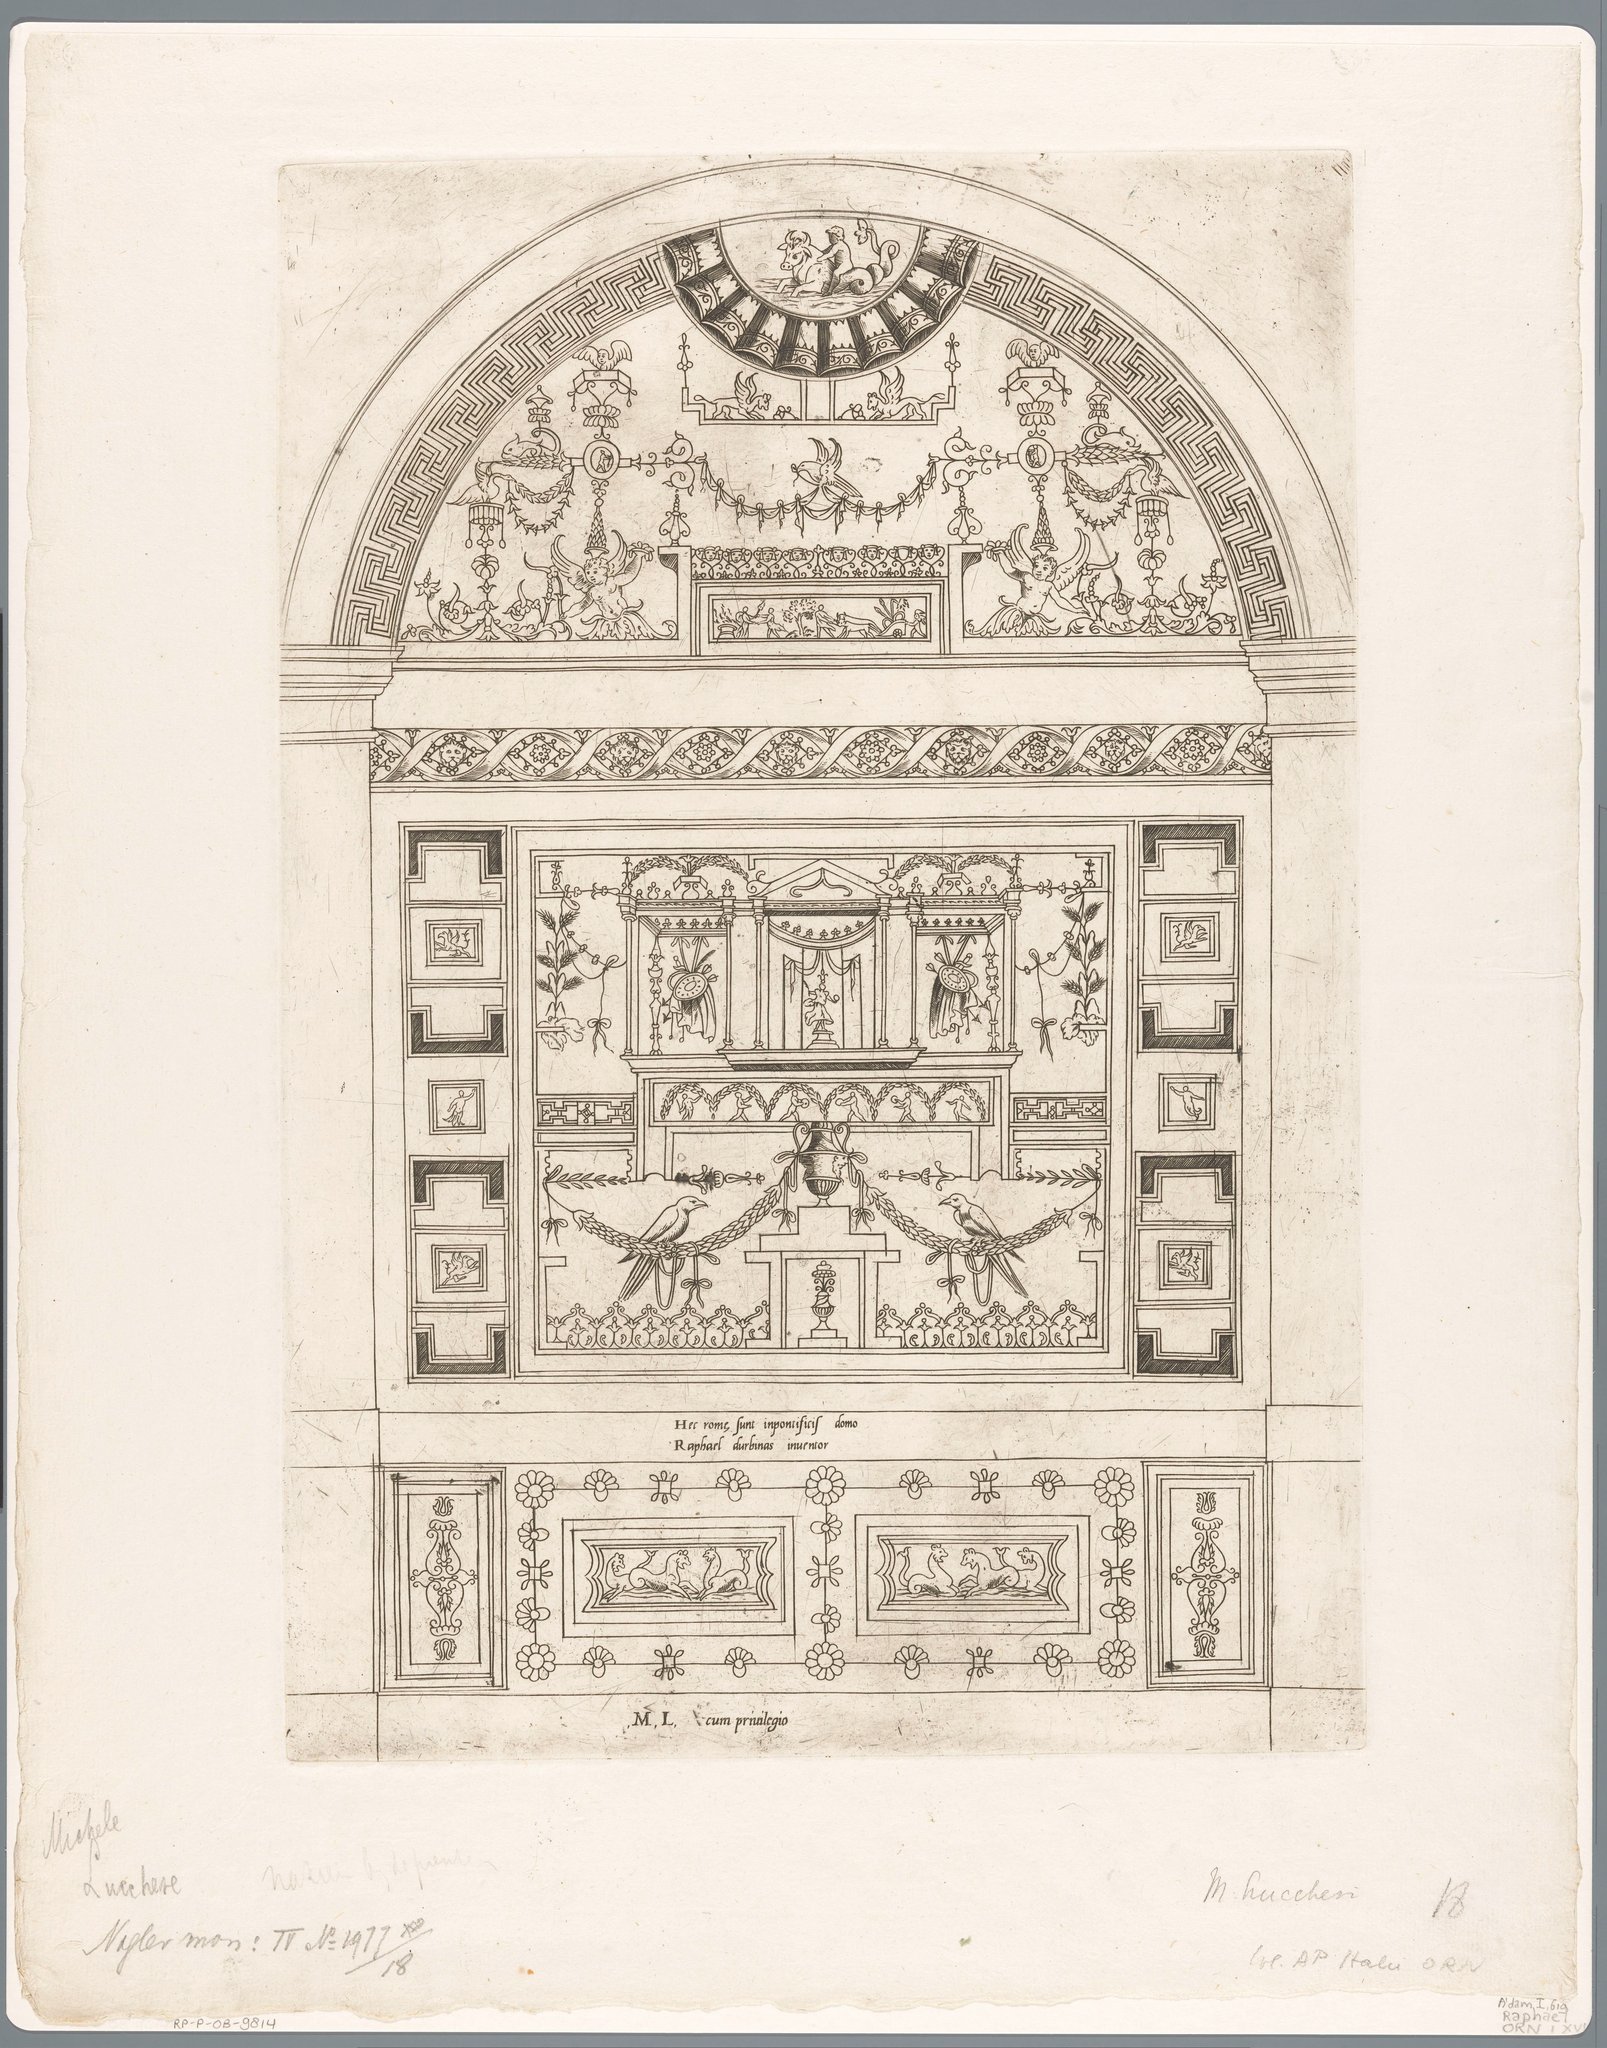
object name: ornament print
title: Groteske wanddecoratie met vogels, hippocampussen, wapens, arabesken en putti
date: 1534-1609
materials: paper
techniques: etching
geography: italy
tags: ornament ~ grotesque, sea-horse, hippocamp, 'hippocampus', (horse/fish) (mythological hybrid monster), birds, cupids: 'amores', 'amoretti', 'putti'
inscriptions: collector's mark: Lugt 2228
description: Wanddecpratie in drie geledingen. Onderaan bevindt zich een lambrizering, gedecoreerd met twee friezen met zeewezens. Daarboven bevindt zich een rechthoekige vlakdecoratie met twee vogels op guirlandes ter weerszijden van een vaas. Bovenaan bevindt zich een halfronde afsluiting met grotesken en een putto op een zeekoe. Deel van wanddecoratie in Loggeta del cardinal Bibbiena in Vaticaanstad.